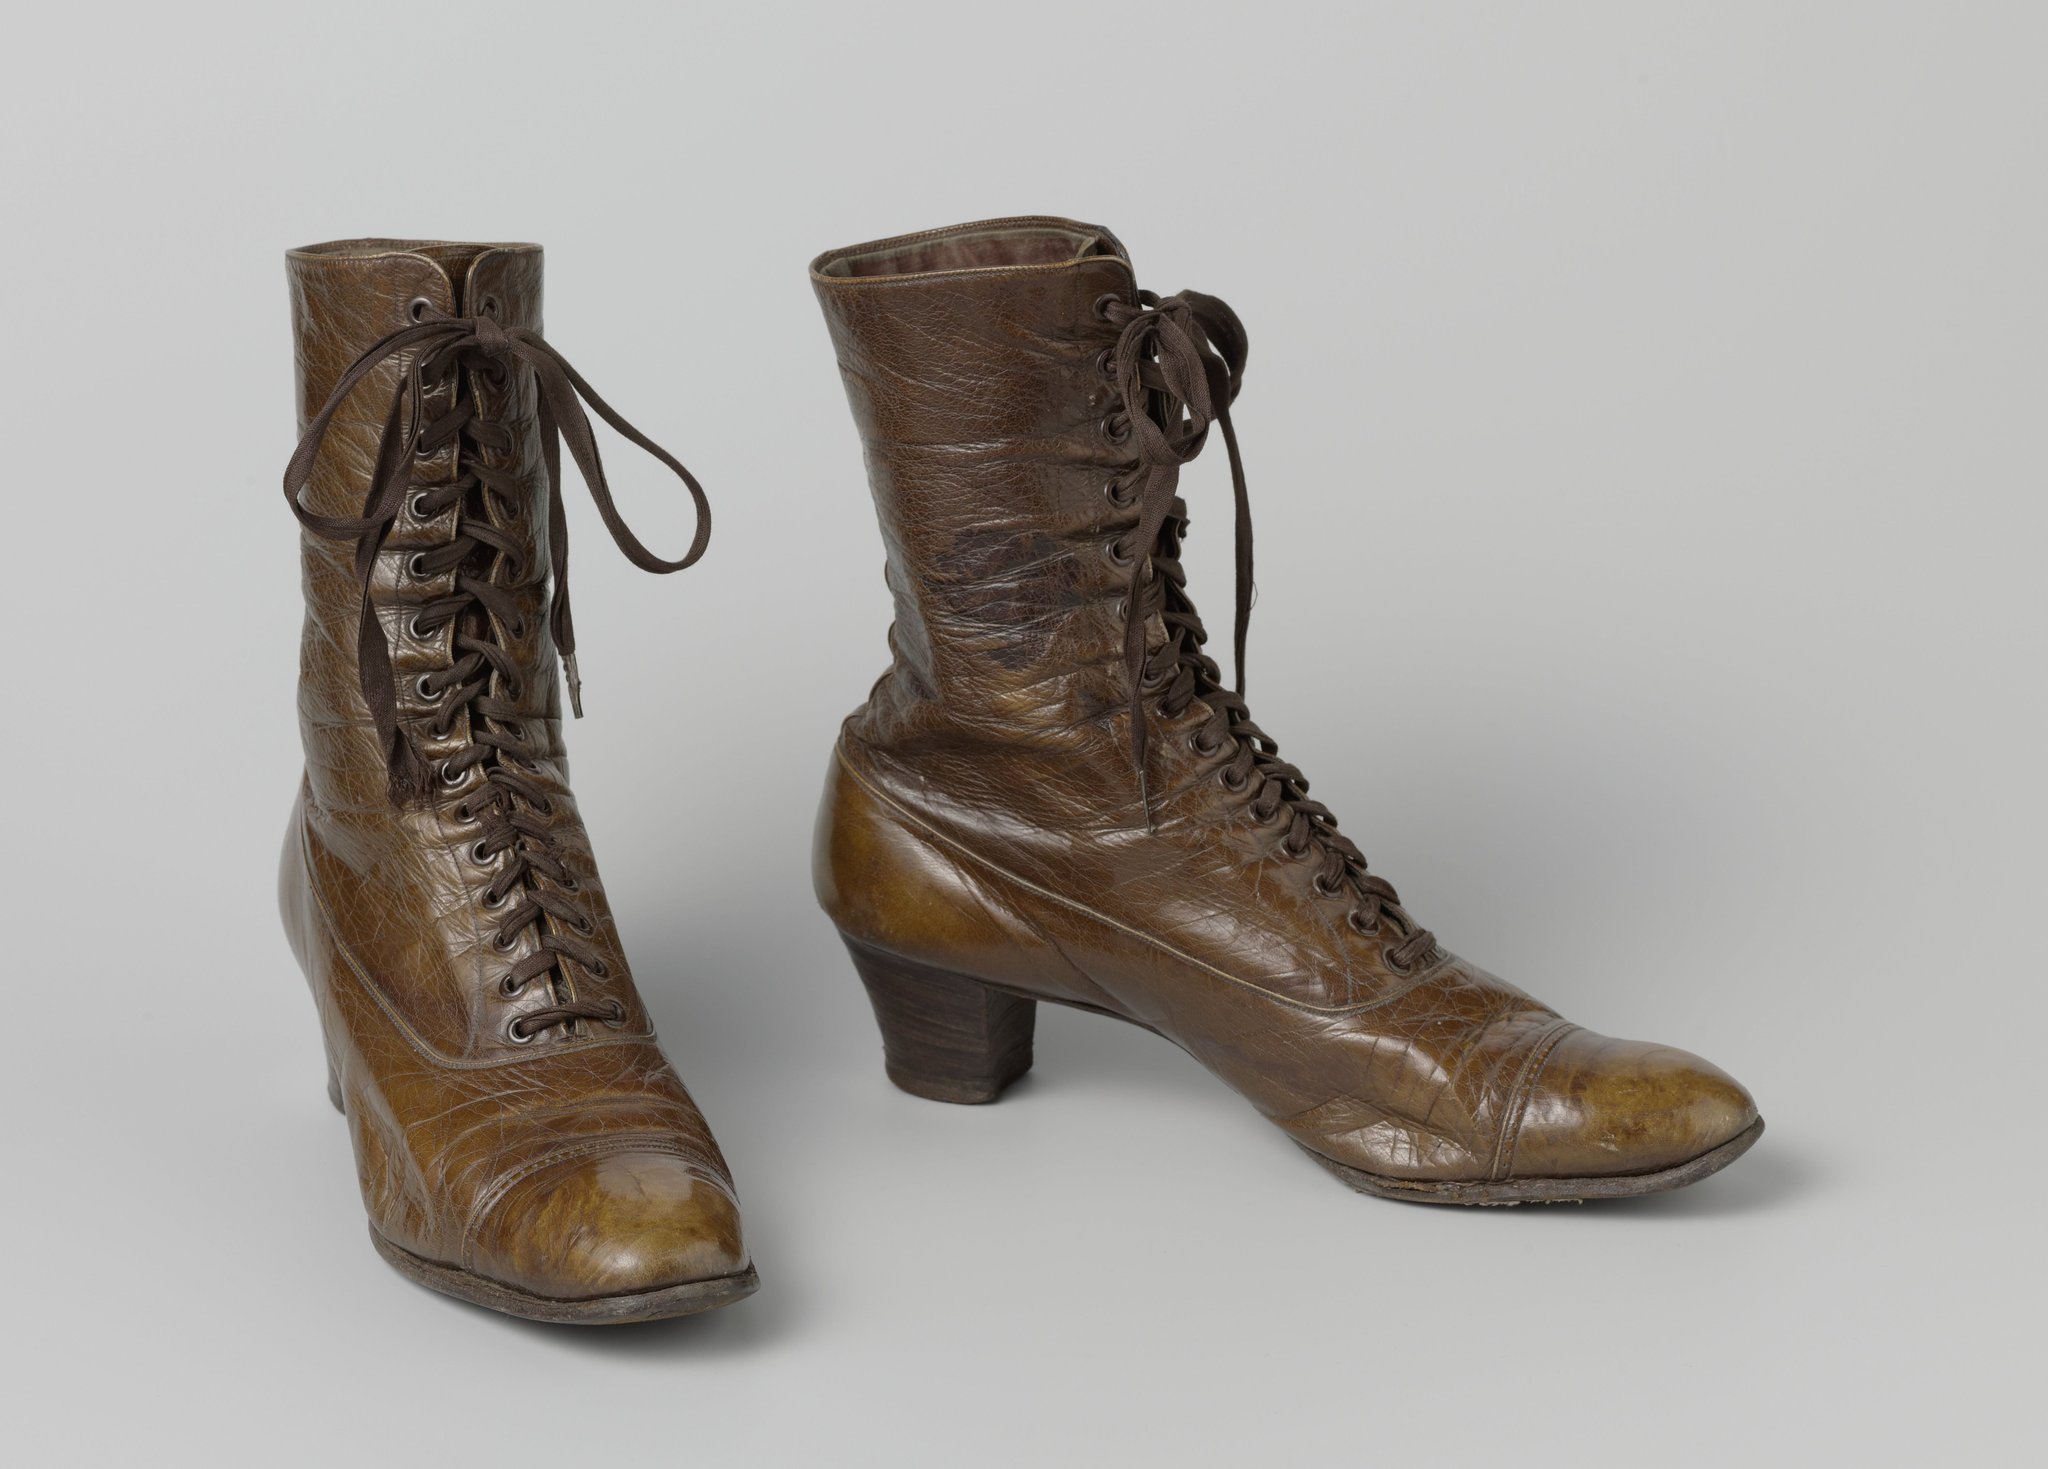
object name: balmoral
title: Rijglaars van bruin leer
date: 1910-1920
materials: cotton, leather, linen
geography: switzerland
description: Linkerrijglaars van bruin leer met extra brede veters. Model hoog met Weense hak van laagjes leer. Gevoerd met linnen. Adres: Bally, importé de Suisse.